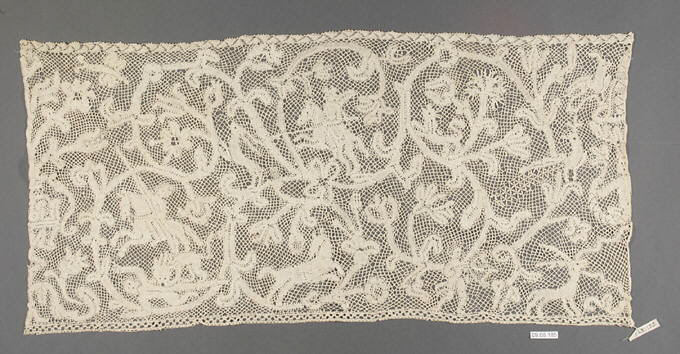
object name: piece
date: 1701-1733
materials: lace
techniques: lace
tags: horses,flowers,leaves